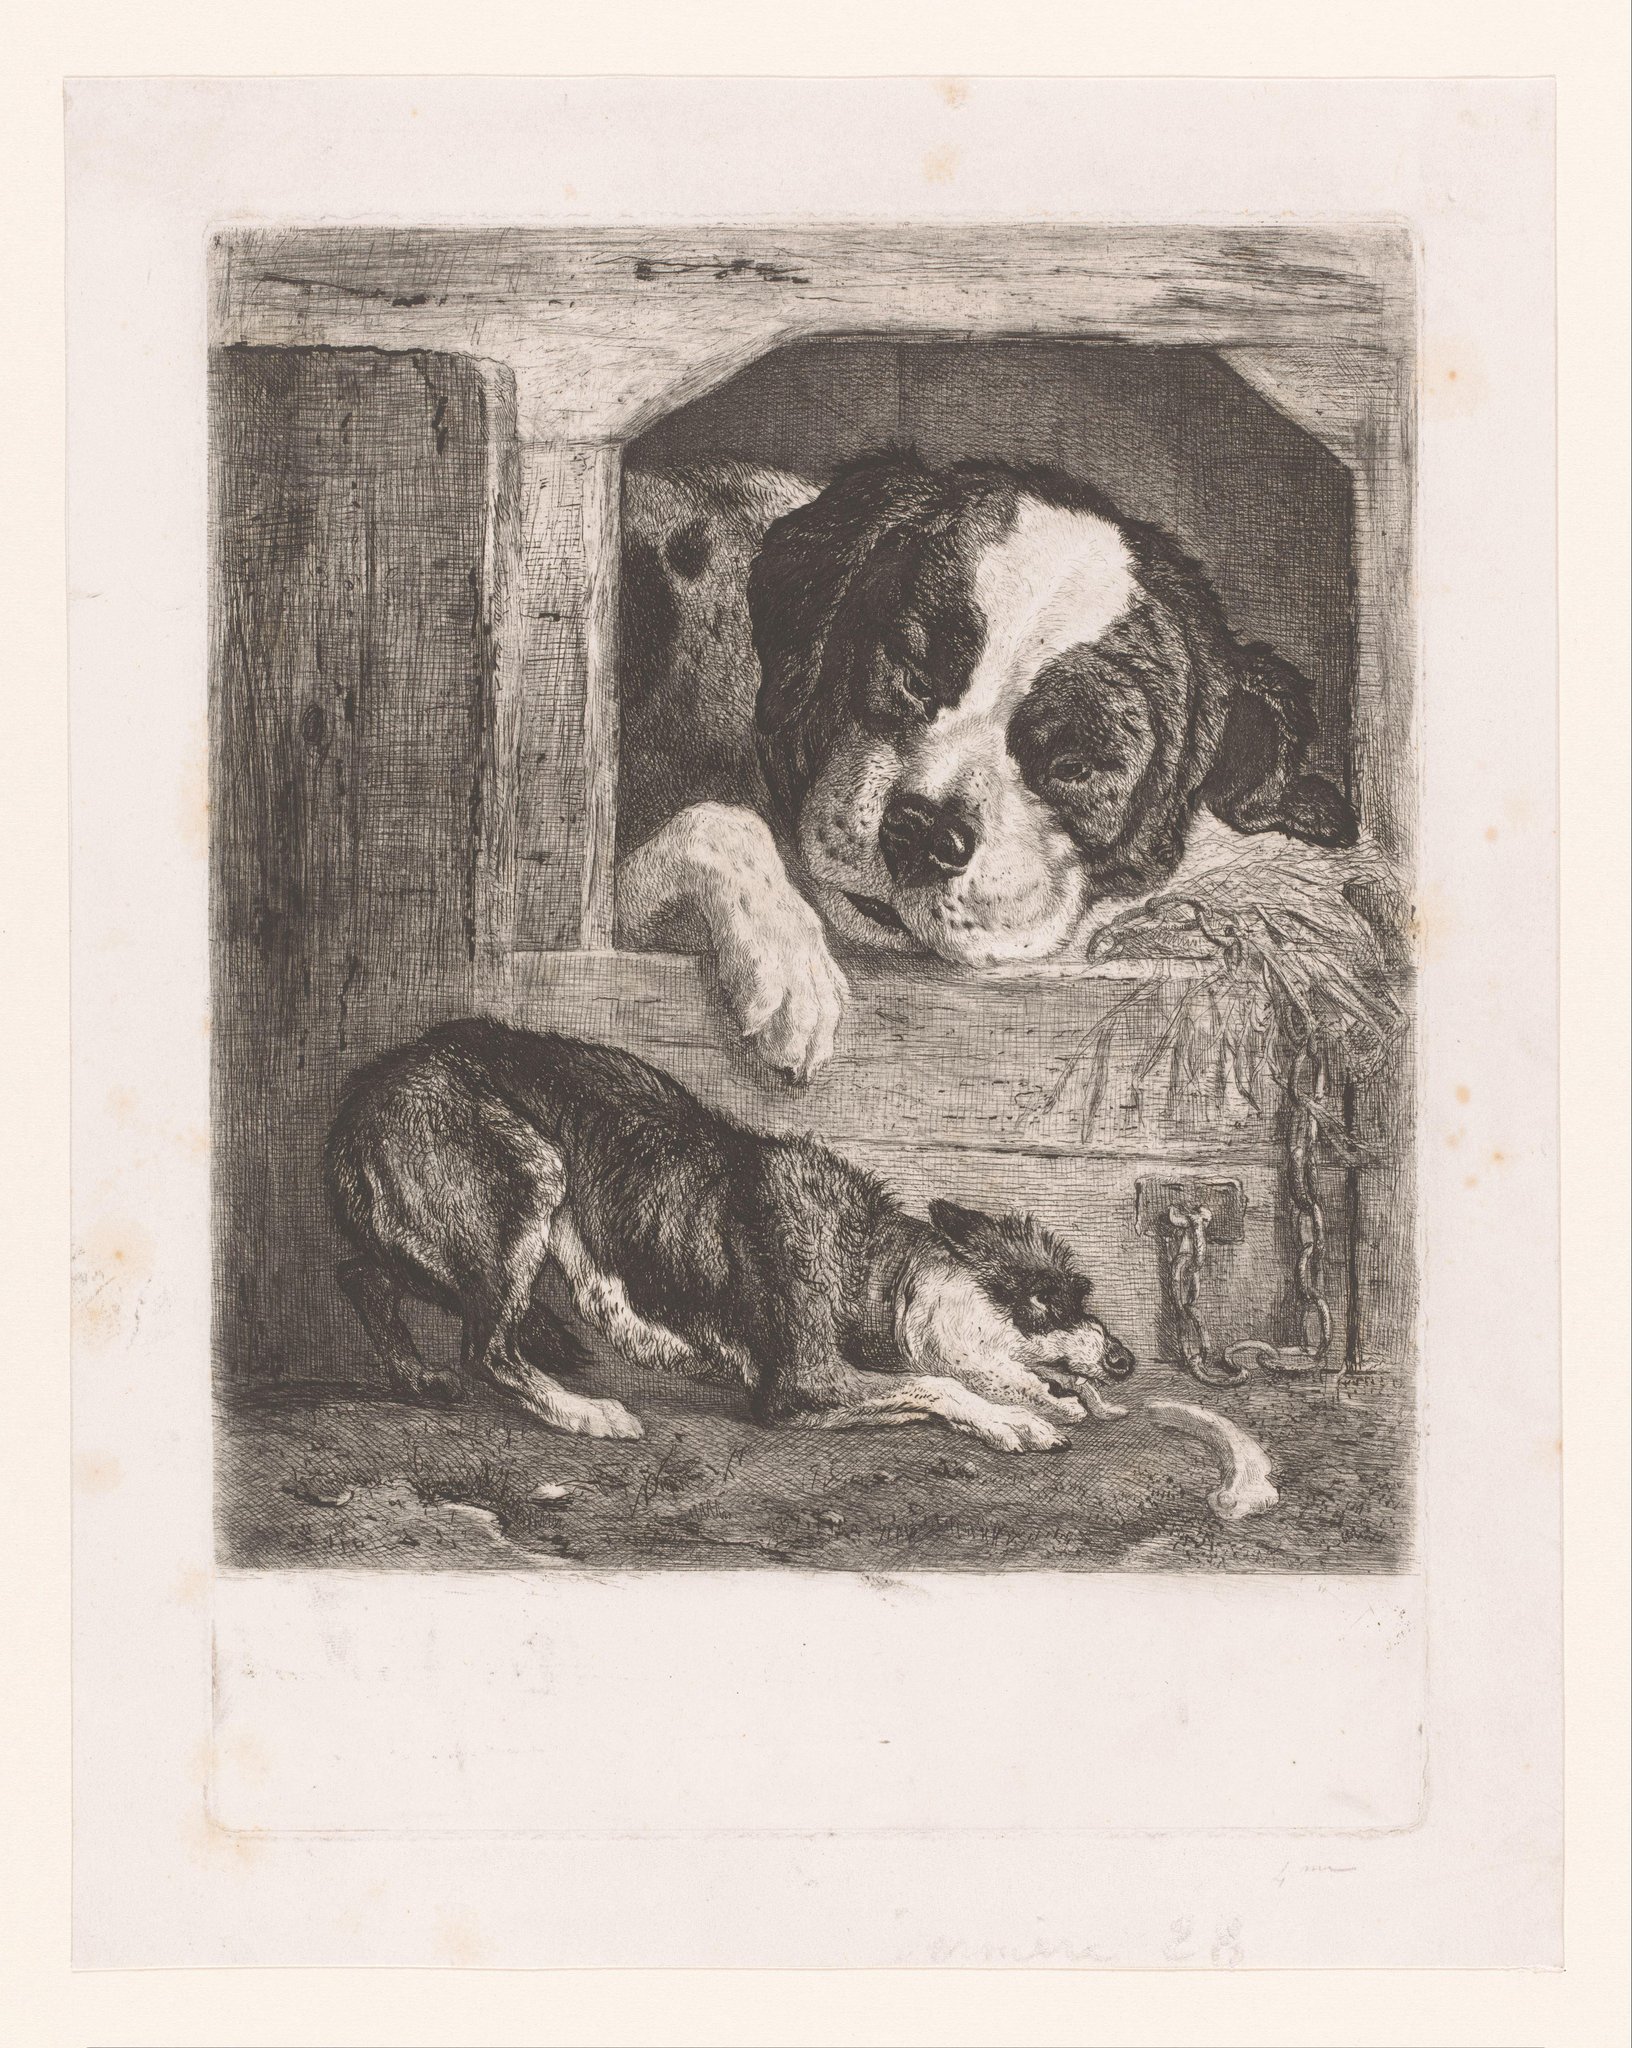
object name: print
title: Twee honden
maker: charles verlat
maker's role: painter, print maker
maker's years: 1824-1890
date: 1834-1890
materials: paper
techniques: drypoint, etching, intaglio, retroussage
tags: dog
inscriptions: collector's mark: Lugt 2228, inscription: ‘derniere E8’